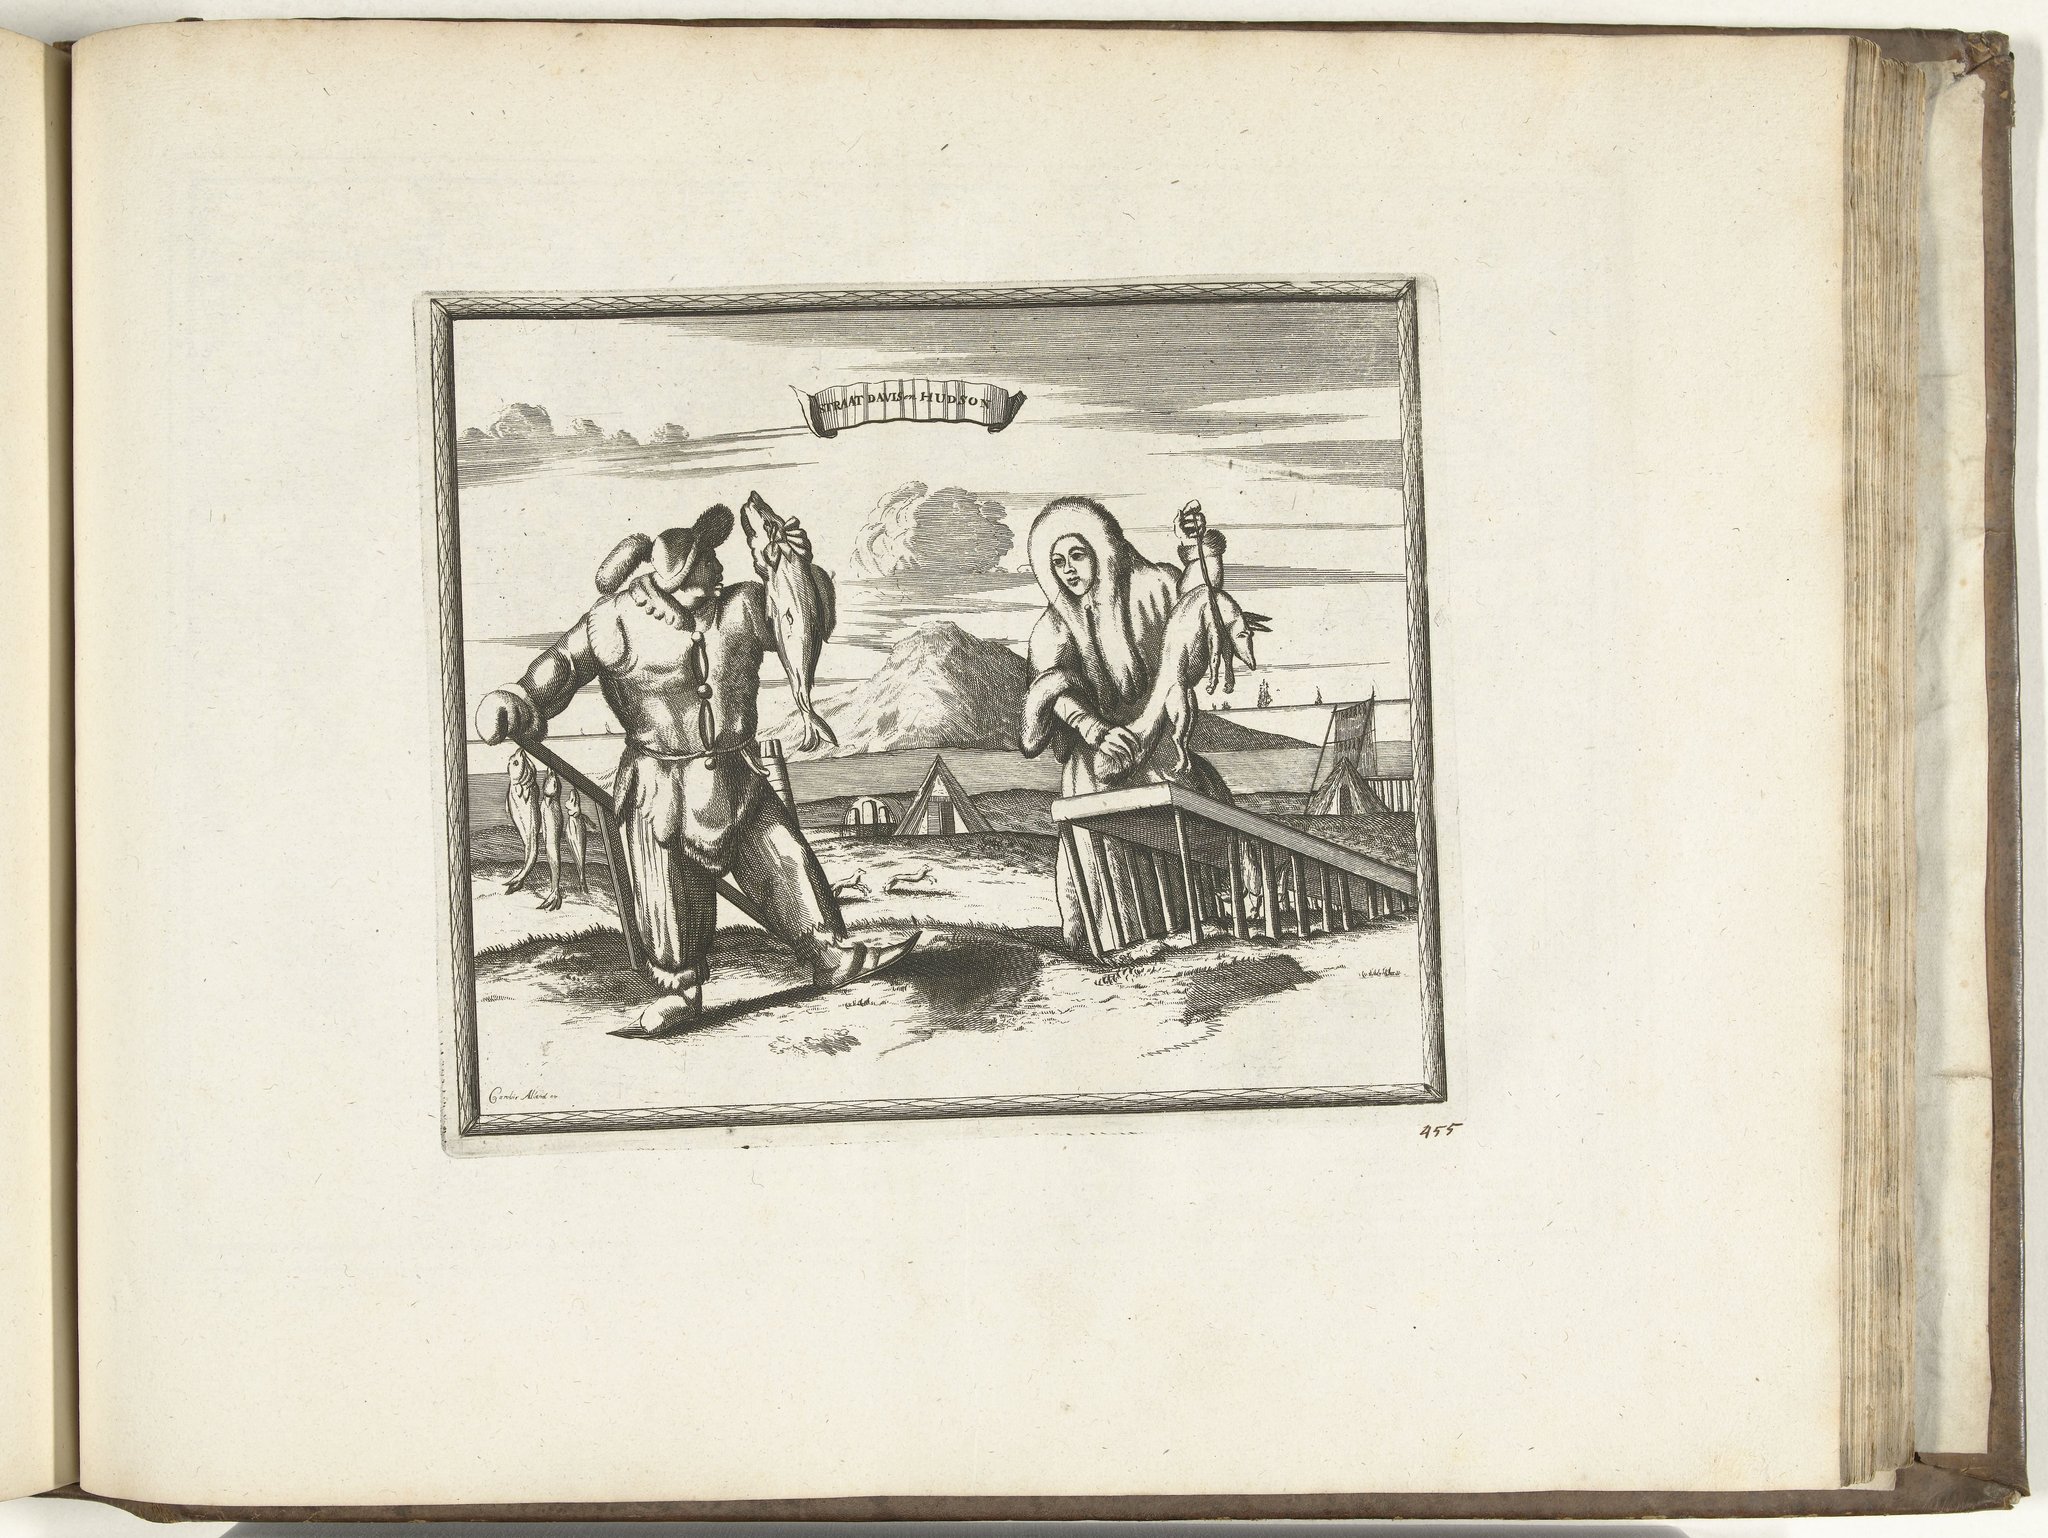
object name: costume print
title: Kostuum van de Straat Davis en Hudson Baai, 1726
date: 1726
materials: paper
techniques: etching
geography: amsterdam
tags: indigenous peoples of the american arctic regions, folk costume, regional costume, canada, greenland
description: Man en vrouw in kostuum van de Straat Davis en Hudson Baai. Plaat nr. 455 in deel XVIII van het prentwerk: Les Forces de l'Europe, Asie, Afrique et Amerique ... Comme aussi les Cartes des Côtes de France et d'Espagne uit 1726, dit tweede deel met 271 met de hand genummerde platen van vermaarde sterke steden en vestingen in het kader van de Spaanse Successieoorlog 1701-1713. Voor het merendeel zijn deze platen gekopieerd naar de anonieme Franse platen van vermaarde sterke steden en vestingen: in Les forces de l'Europe en in: Le theatre de la guerre, dans les Pays-Bas, beide oorspronkelijk uitgegeven door Nicolas de Fer te Parijs (1693-1697) in het kader van de Negenjarige Oorlog.